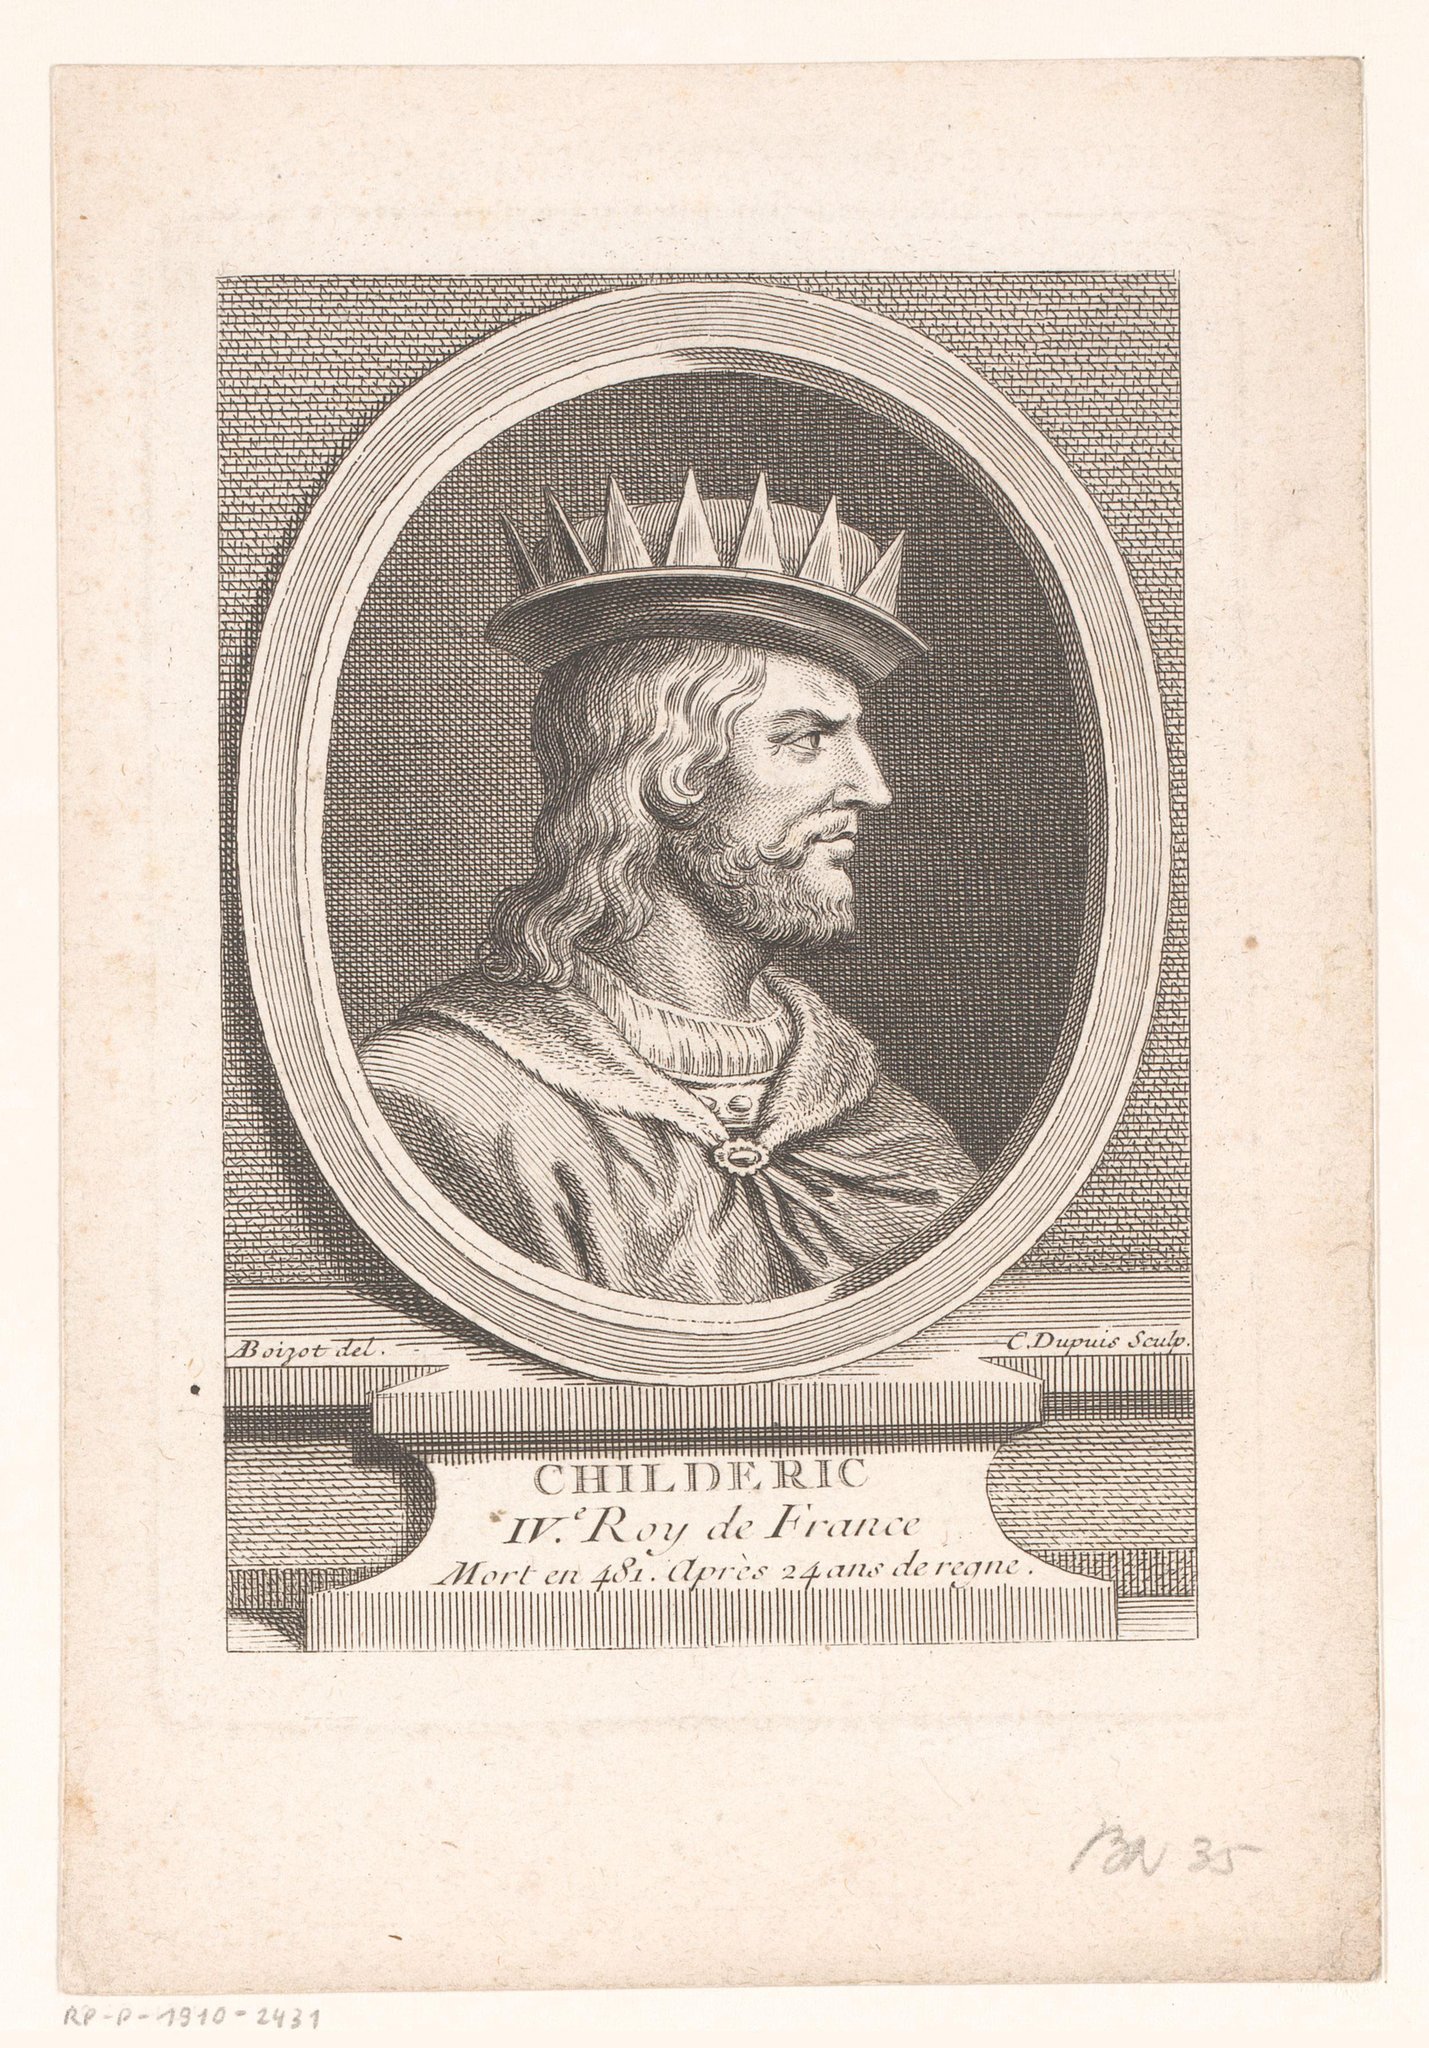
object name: print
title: Childeric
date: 1739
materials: paper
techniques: engraving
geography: france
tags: ornament ~ medallion, historical persons, ruler, sovereign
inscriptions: collector's mark: Lugt 2228